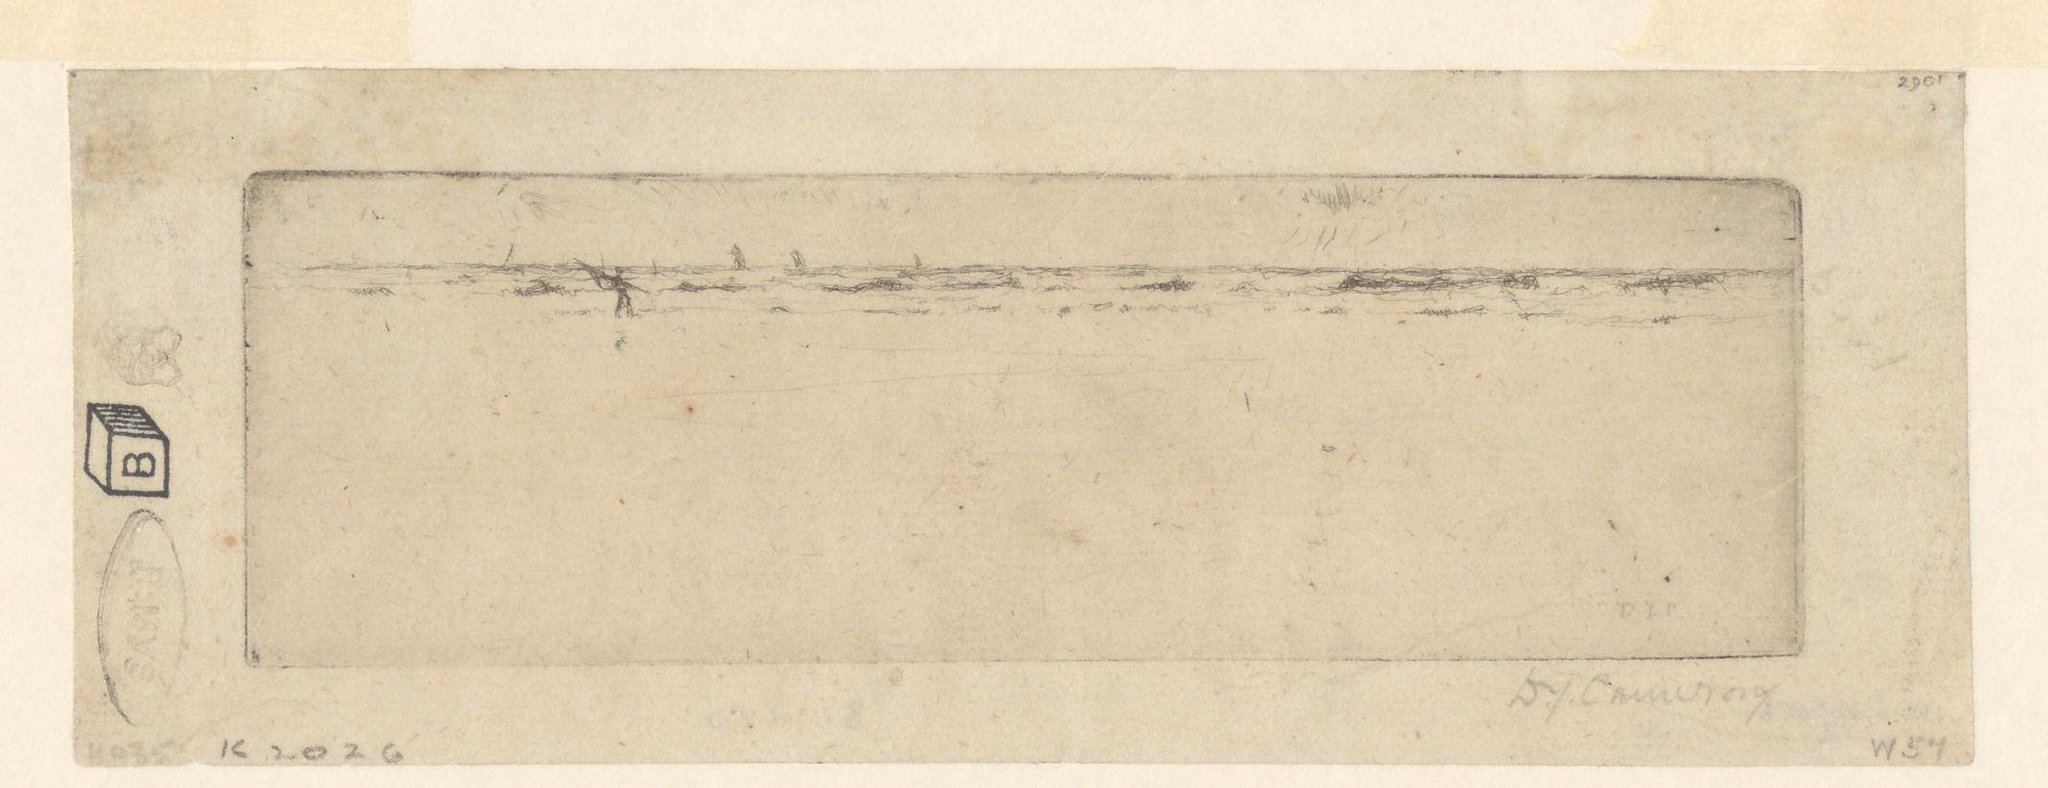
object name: print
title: Gezichten in Noord-Holland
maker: david young cameron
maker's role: draughtsman, print maker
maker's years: 1865-1945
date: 1892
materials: paper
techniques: etching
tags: beach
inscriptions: collector's mark: Lugt 2760, collector's mark: Lugt 2228, collector's mark: Lugt 342a